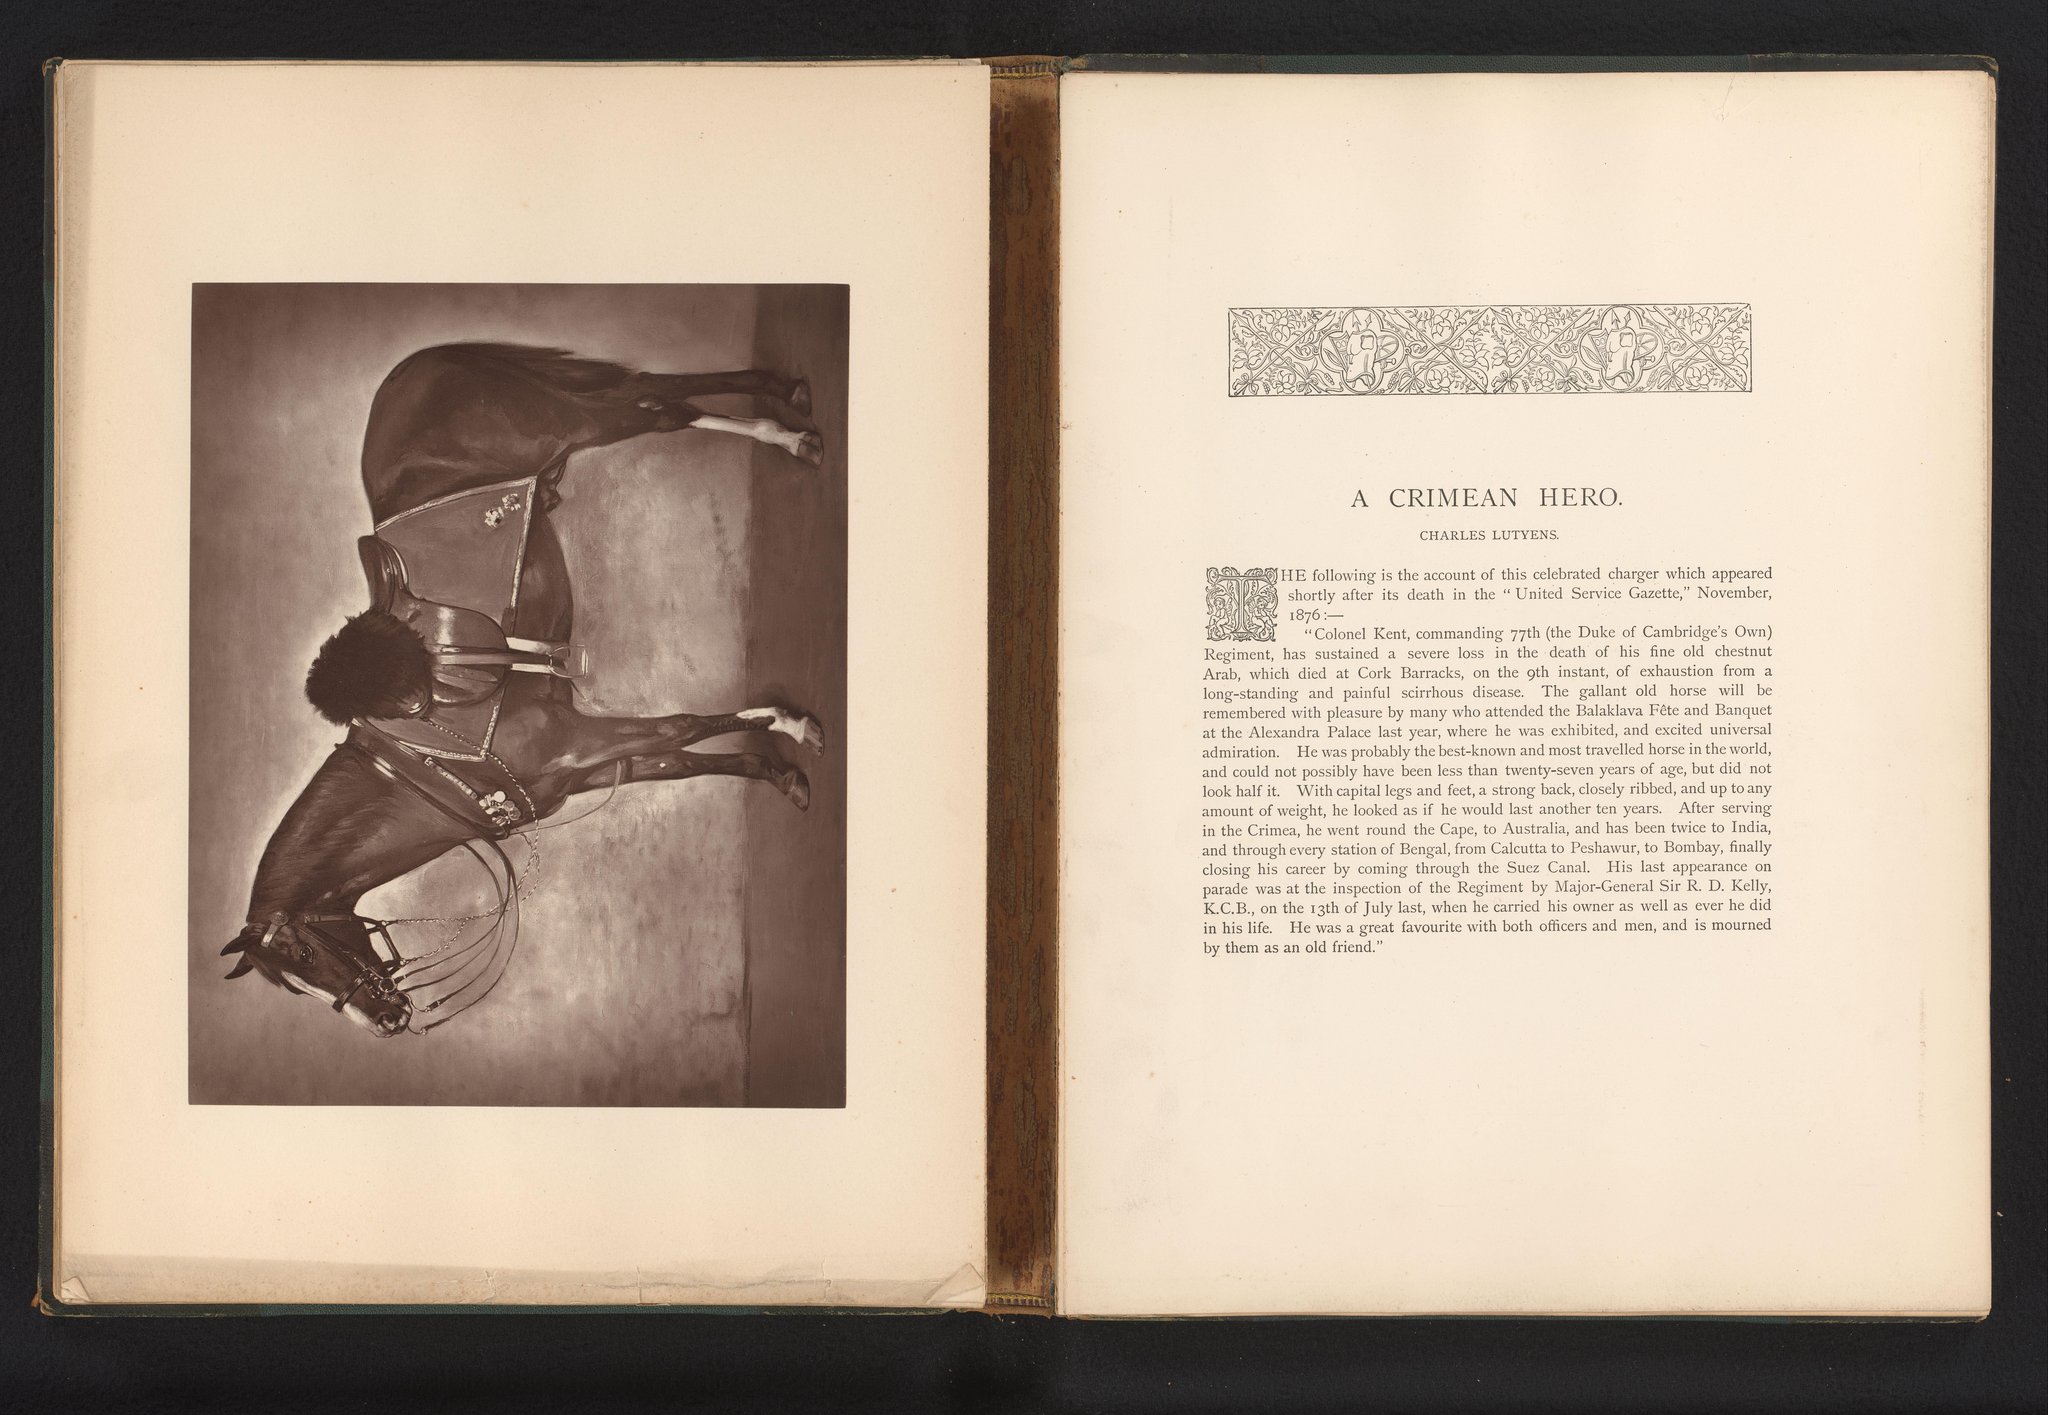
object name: reproduction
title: Reproductie van een schilderij van een paard door Charles Lutyens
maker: Anonymous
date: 1874-1879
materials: paper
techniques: woodburytype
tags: horse